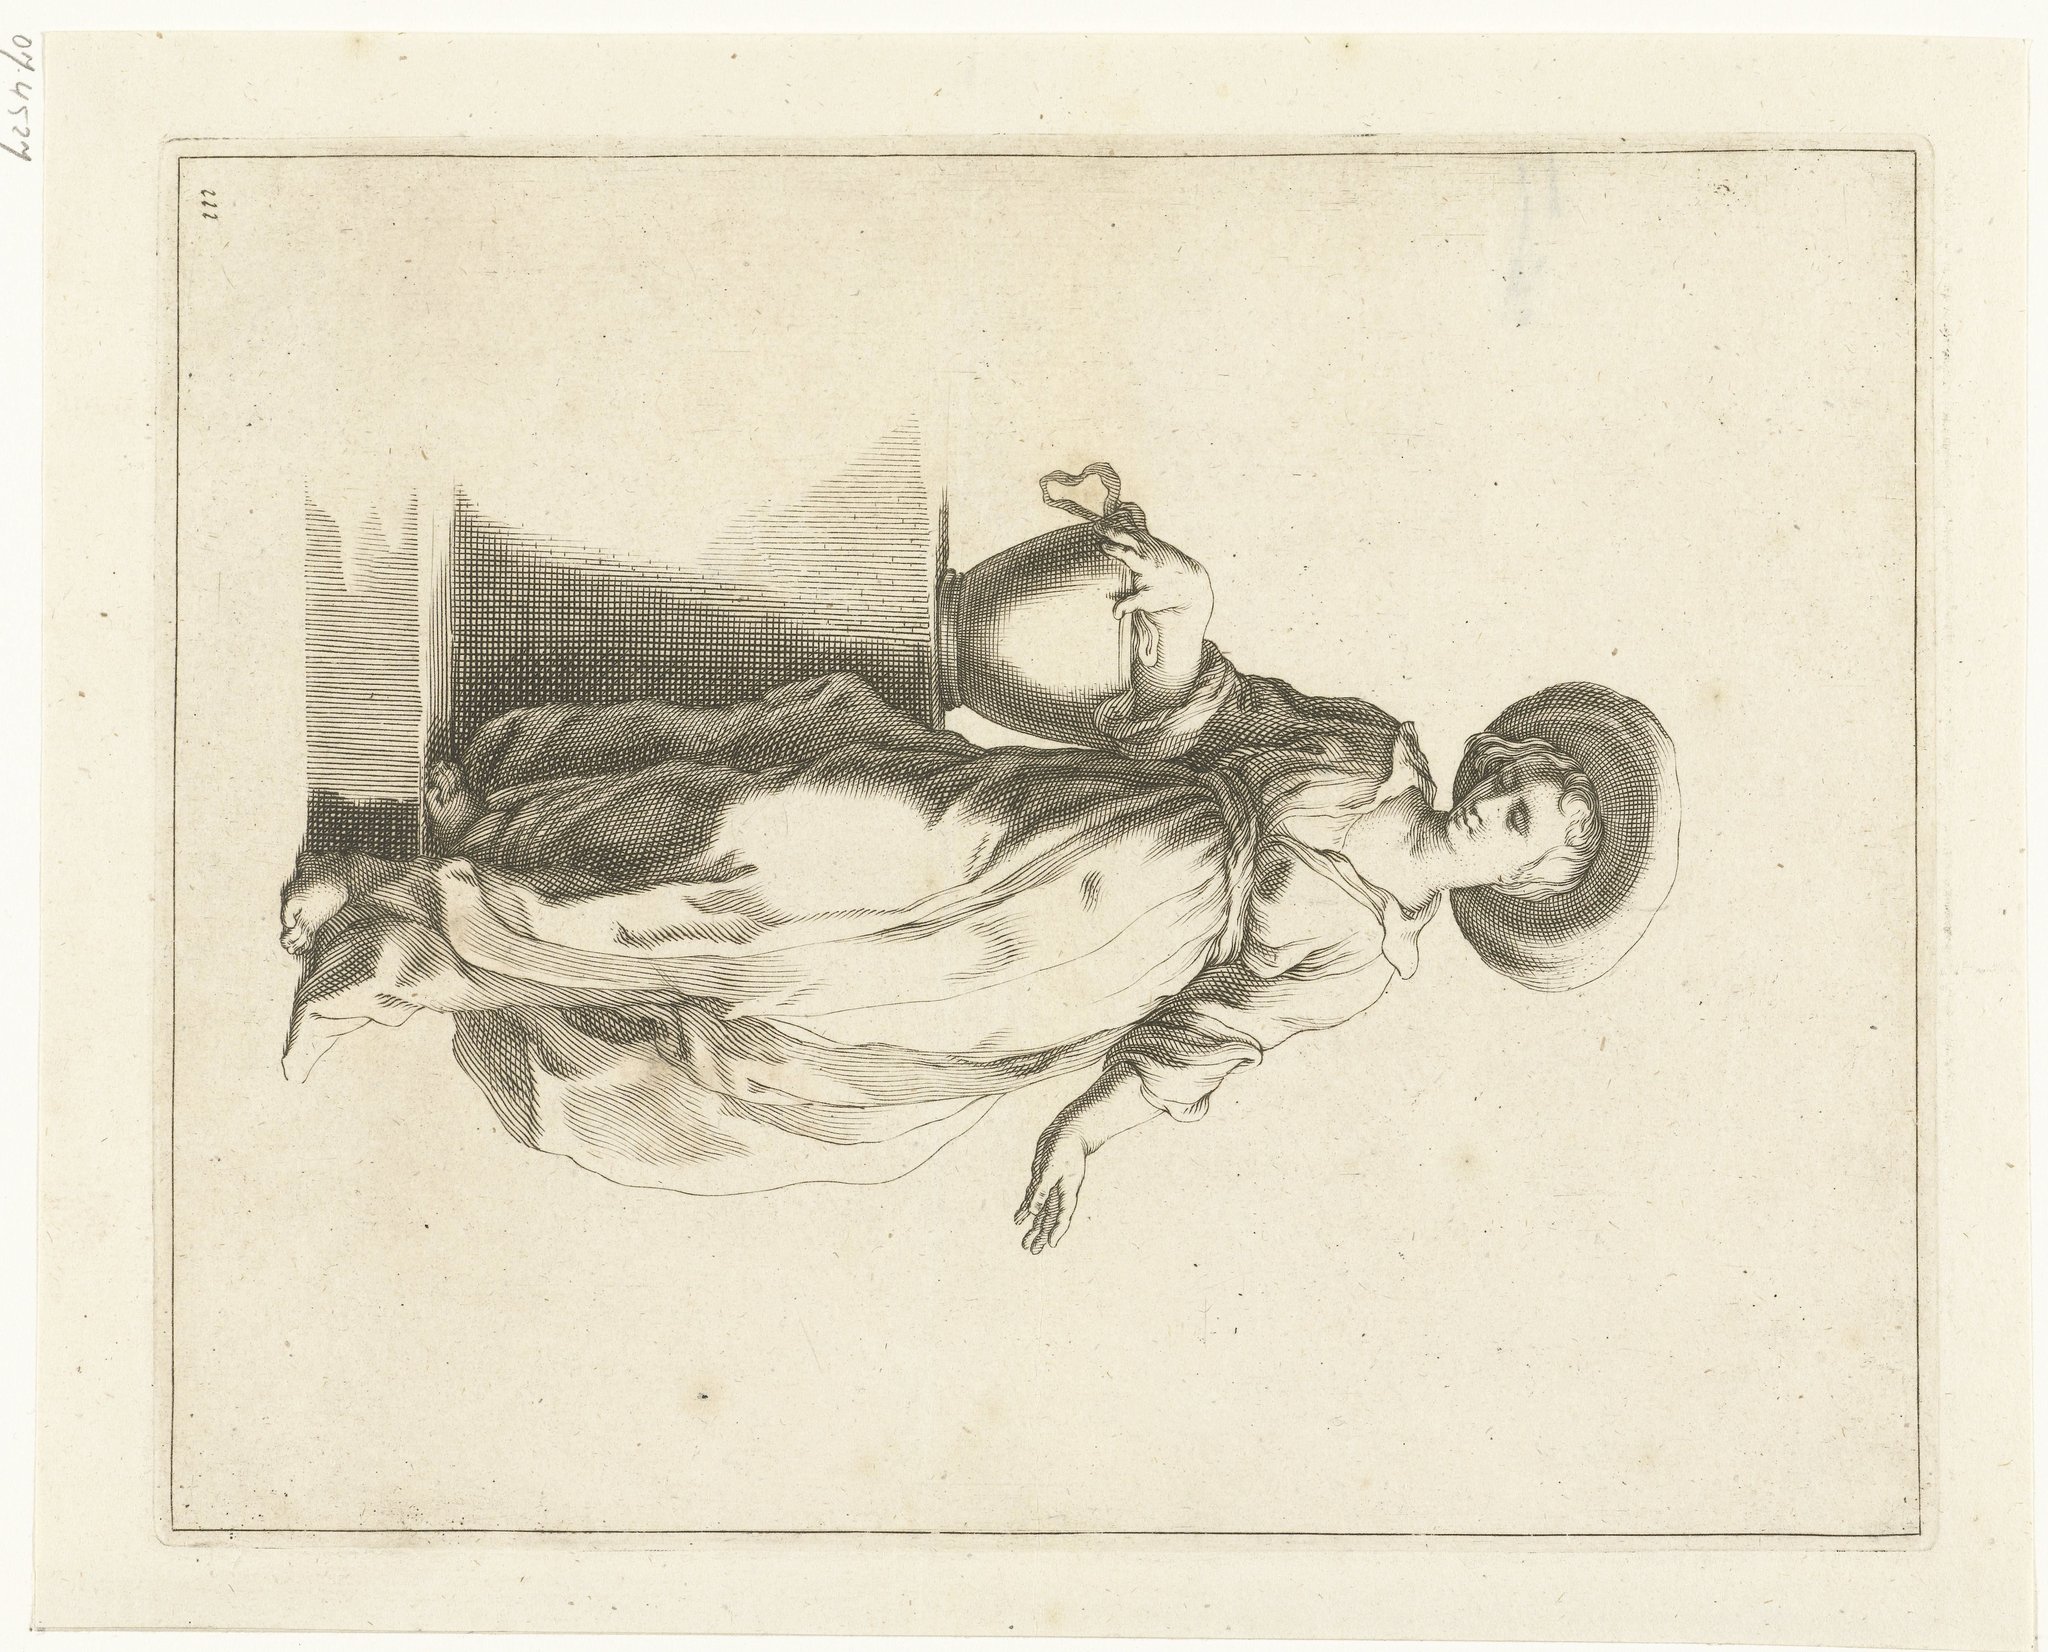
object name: print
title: Het tekenboek van Abraham Bloemaert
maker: frederick bloemaert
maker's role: print maker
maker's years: 1614-1669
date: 1650-1700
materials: paper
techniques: engraving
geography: utrecht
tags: adult woman, the woman of samaria (john 4:4-42)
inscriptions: collector's mark: Lugt 2228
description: Een vrouw leunt tegen een laag muurtje. Haar rechterarm rust op een emmer. In een tekening van Christus en de Samaritaanse vrouw door Abraham Bloemaert, komt dezelfde figuur voor.